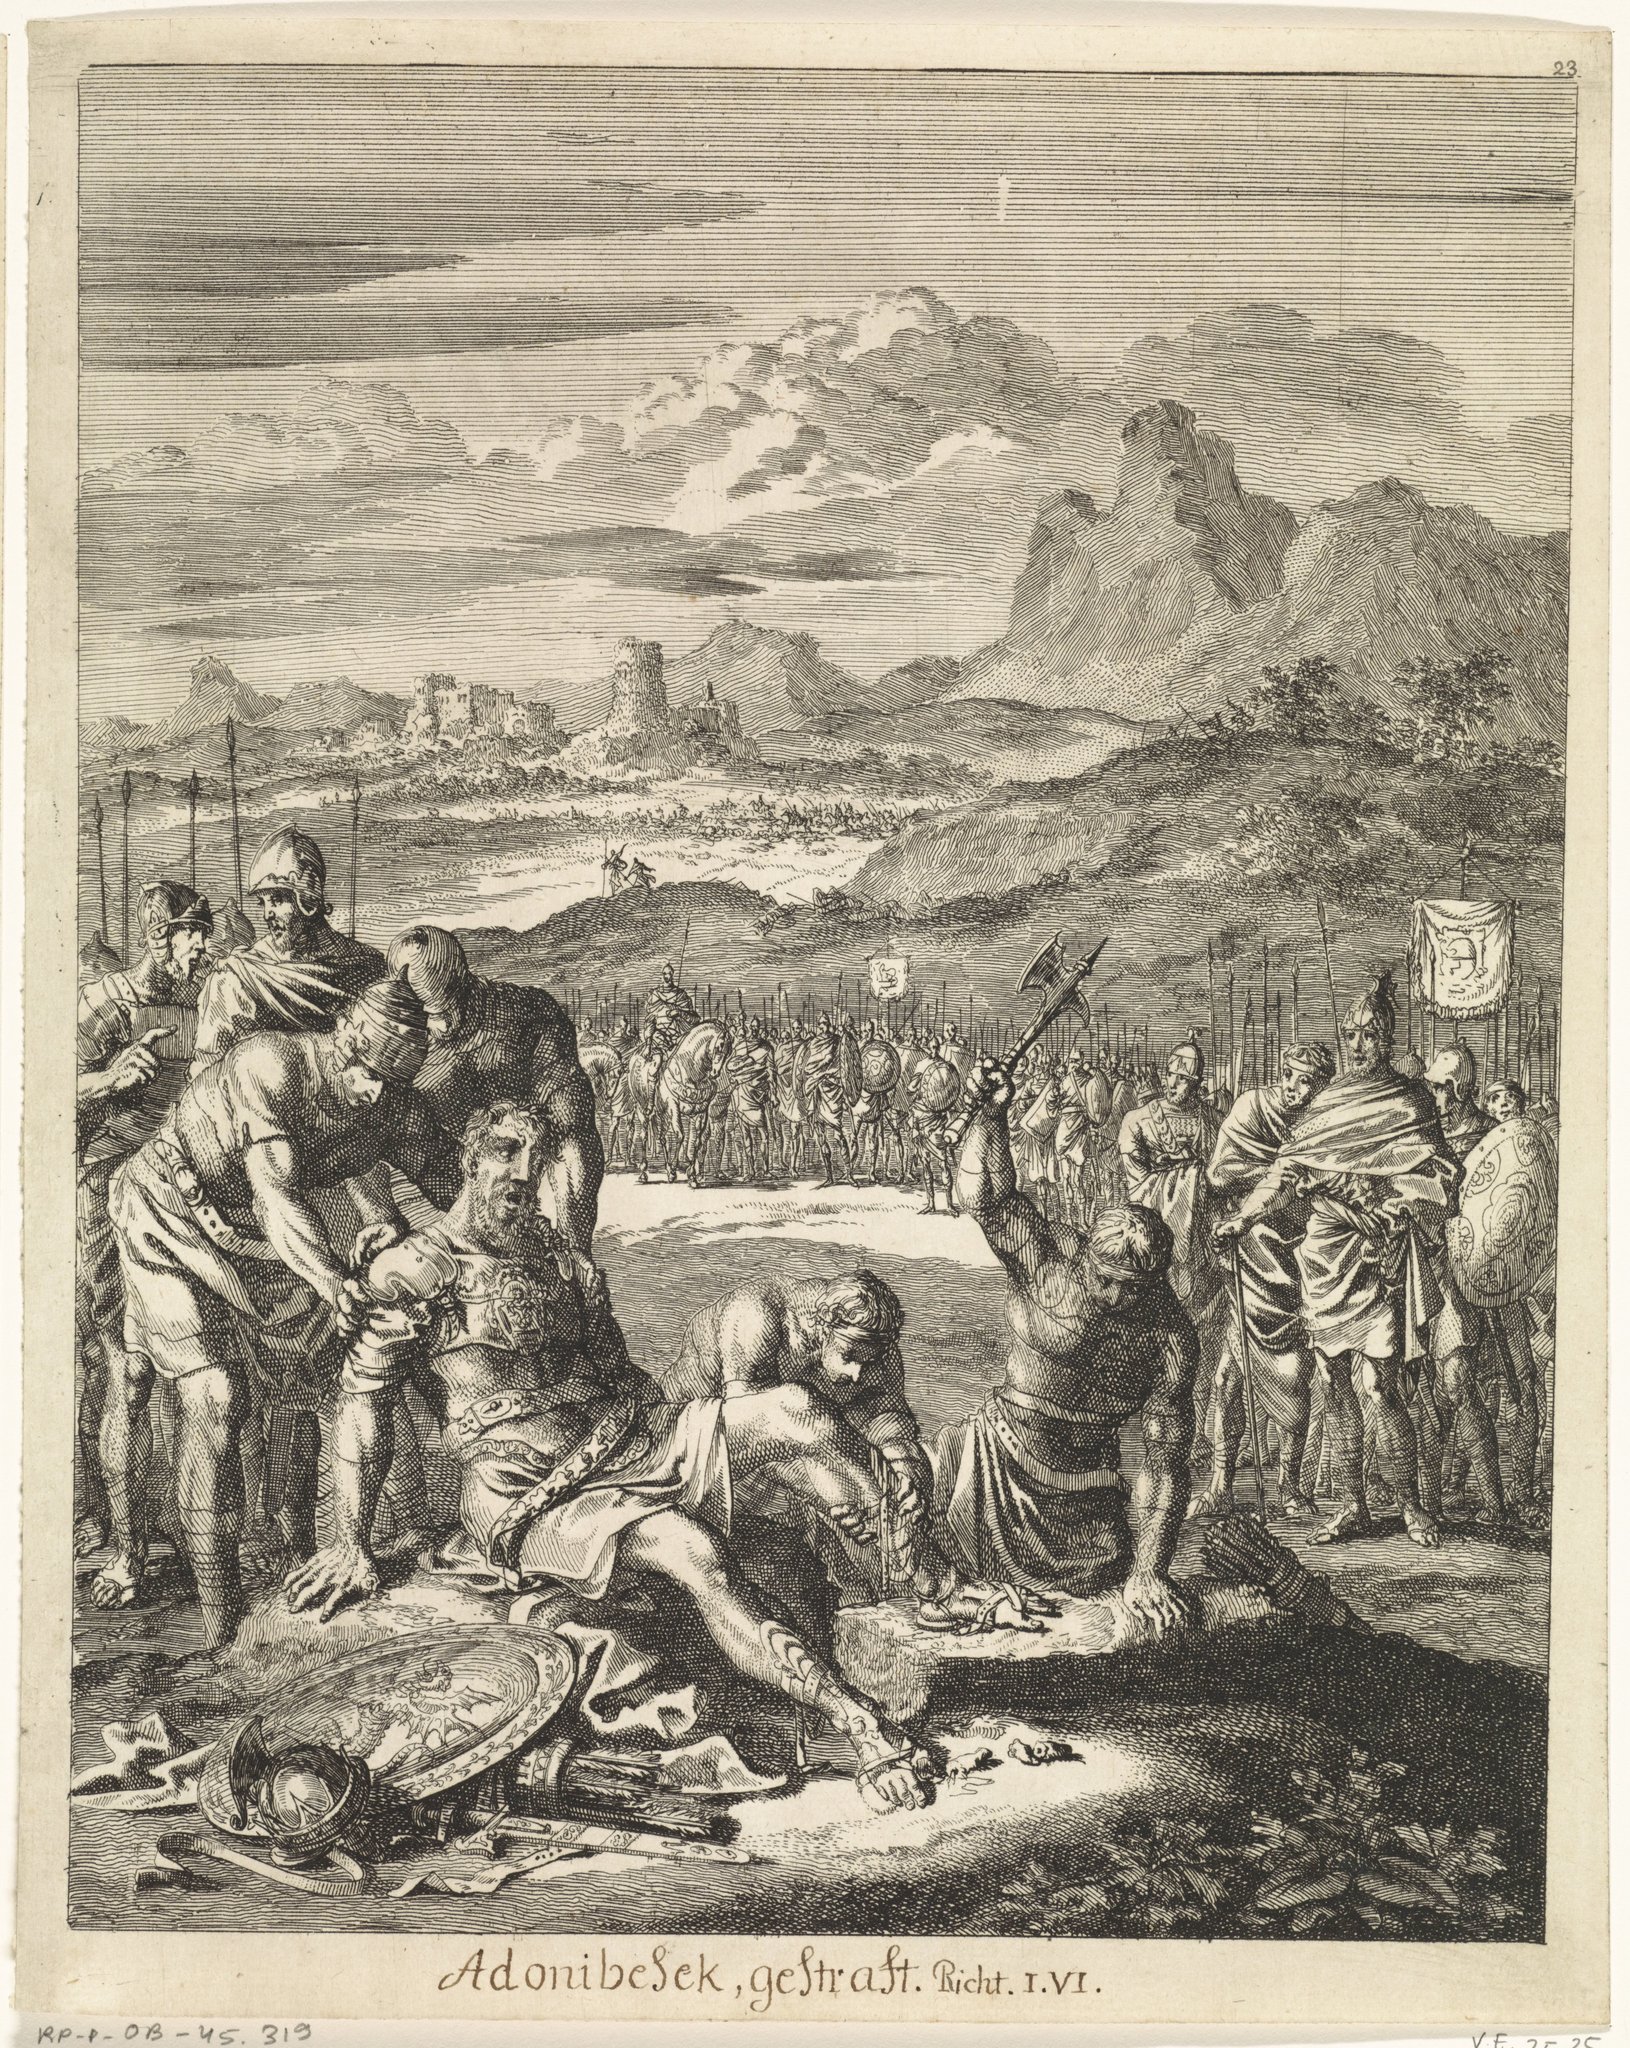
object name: print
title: Verminking van Adonibezek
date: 1708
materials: paper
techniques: etching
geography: amsterdam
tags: adoni-bezek is caught; his thumbs and his great toes are cut off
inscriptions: collector's mark: Lugt 2228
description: Proefdruk van een prent welke is opgenomen als illustratie in: Historiae Celebriores Veteris Testamenti. Christoph Weigel, 1708.